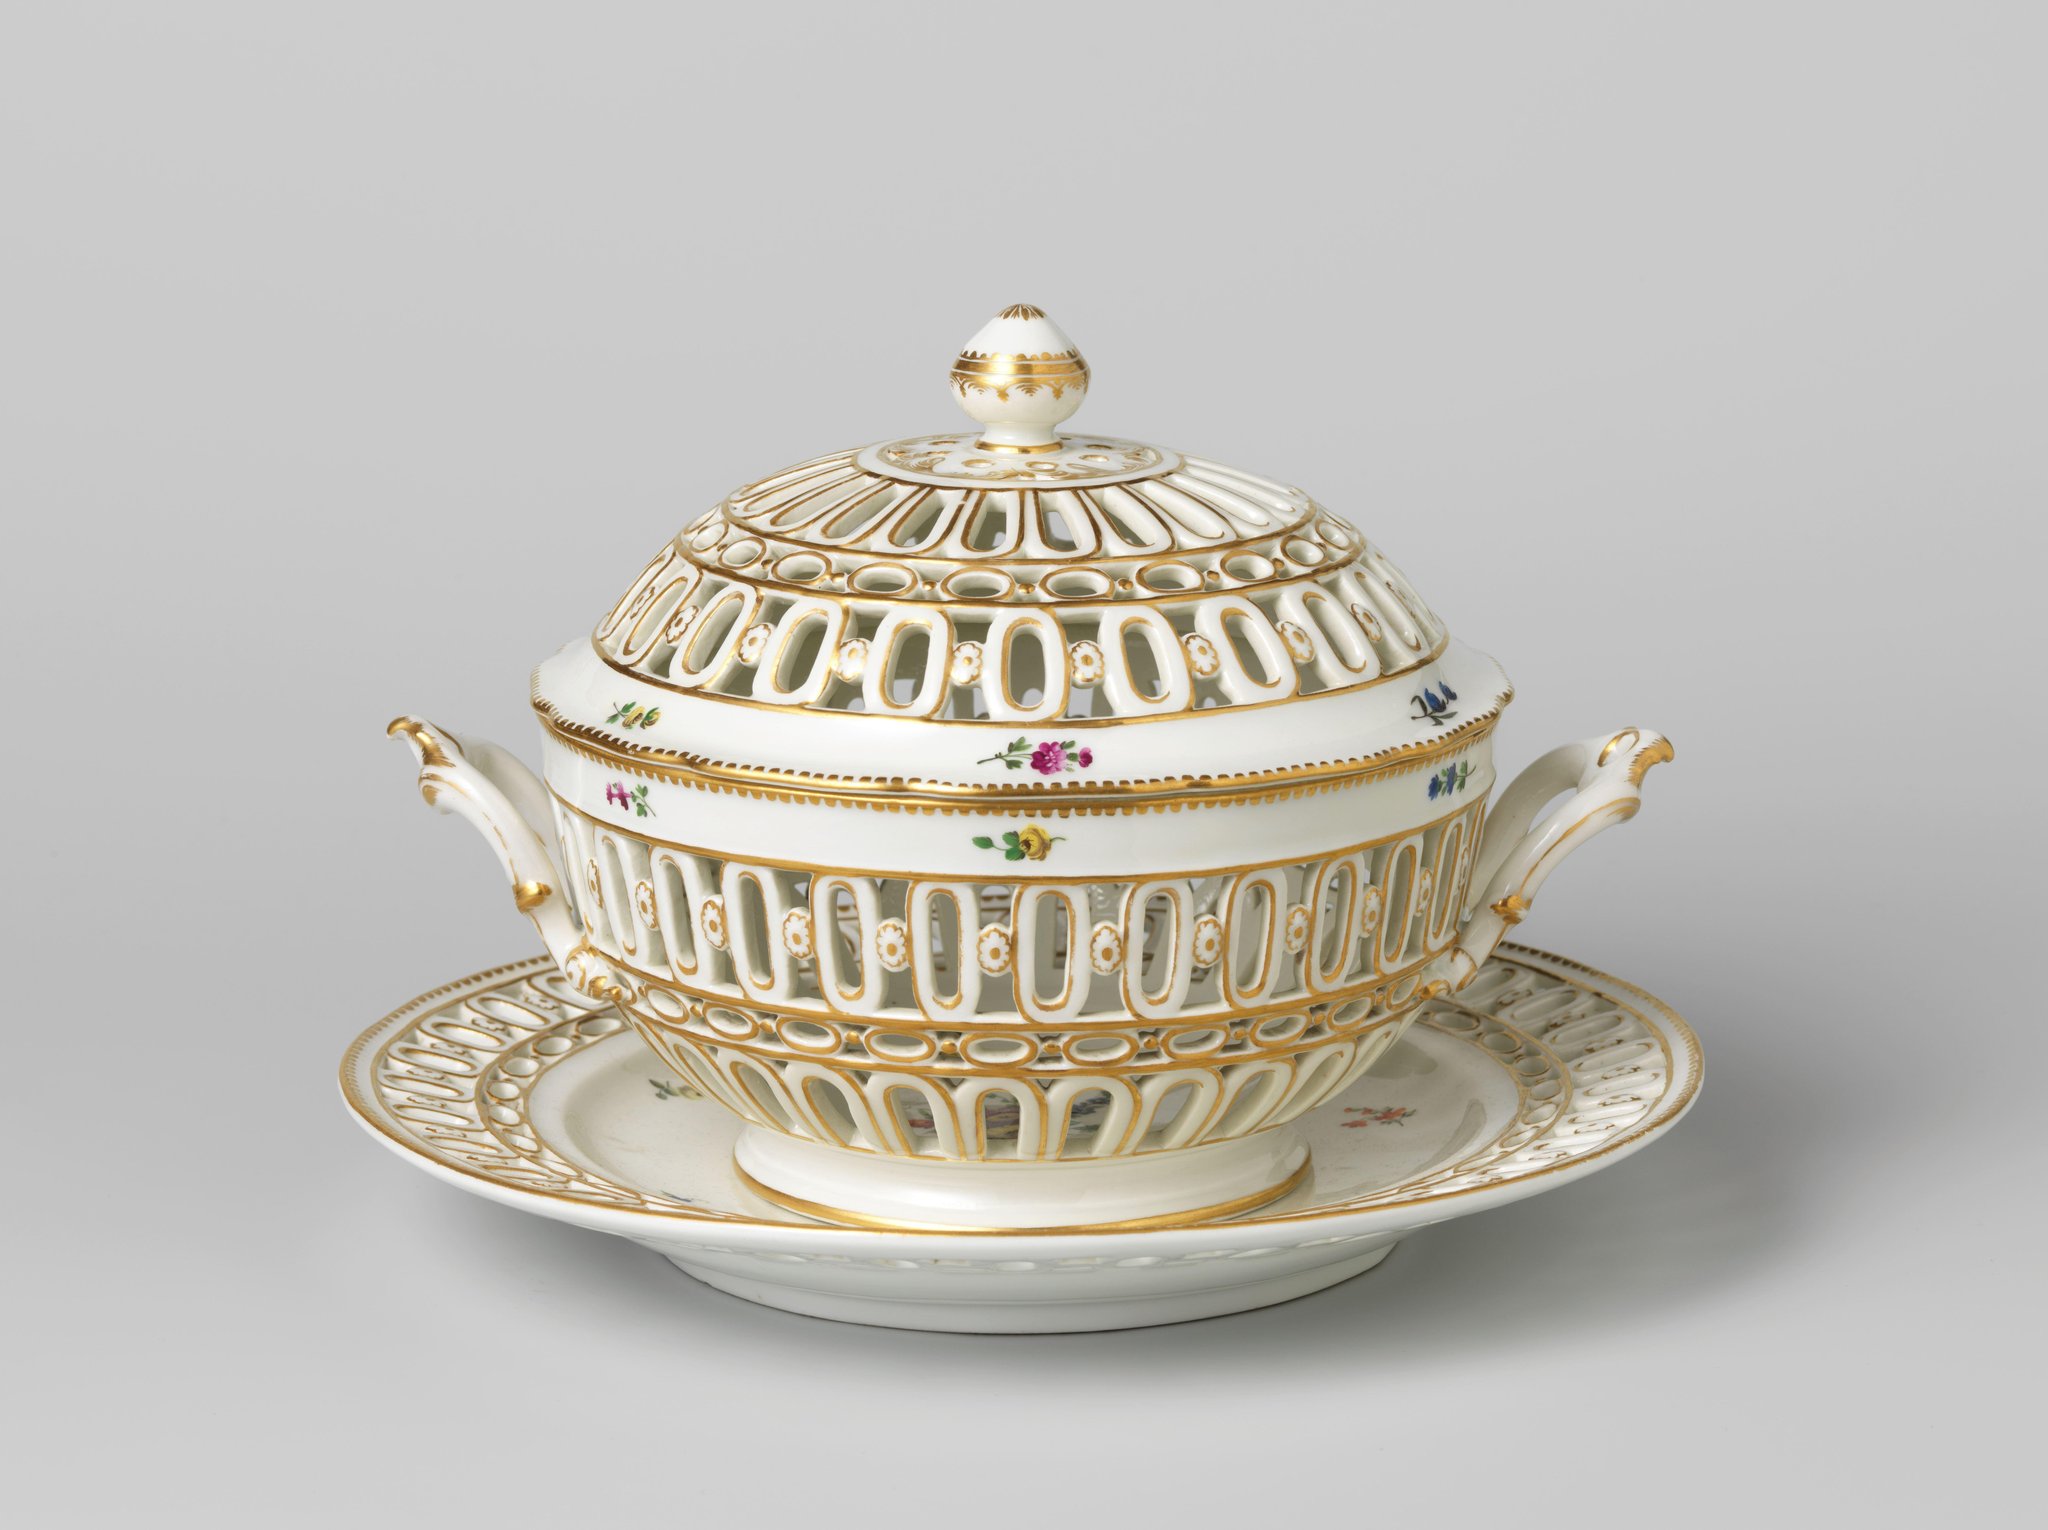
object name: lid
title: Deksel opengewerkt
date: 1782-1784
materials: porcelain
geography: loosdrecht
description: Deksel van porselein. Met plastisch versierde oren. Mand en deksel zijn opengewerkt. Op de buitenranden veelkleurige strooibloempjes, evenals op de bodem van de mand. Het bovenvlak van het deksel en de knop zijn ook met goud beschilderd, evenals de oren.